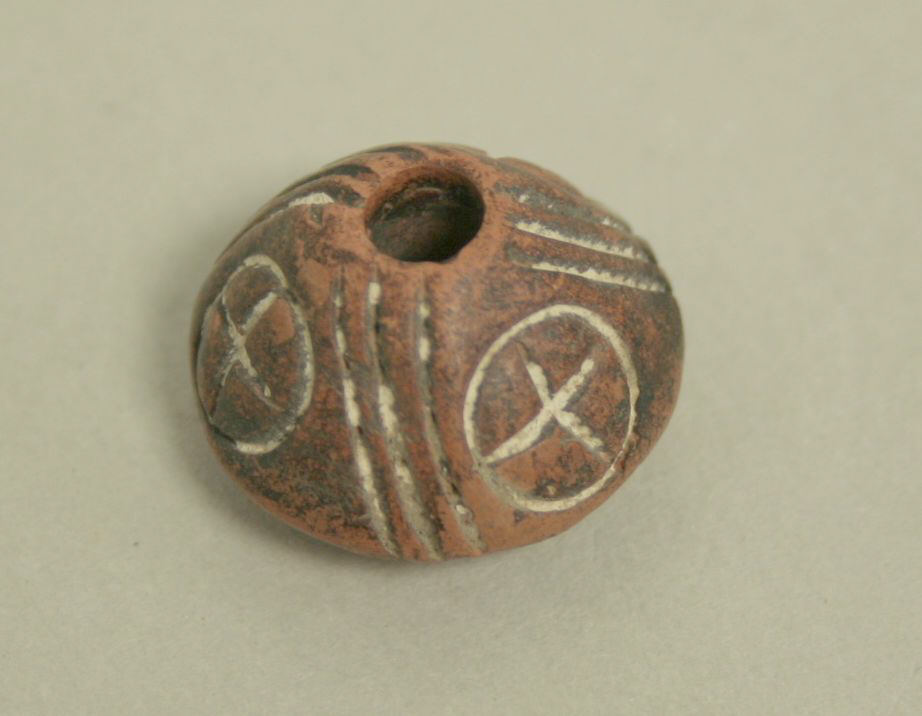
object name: spindle whorl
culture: peruvian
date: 1-500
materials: ceramic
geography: peru